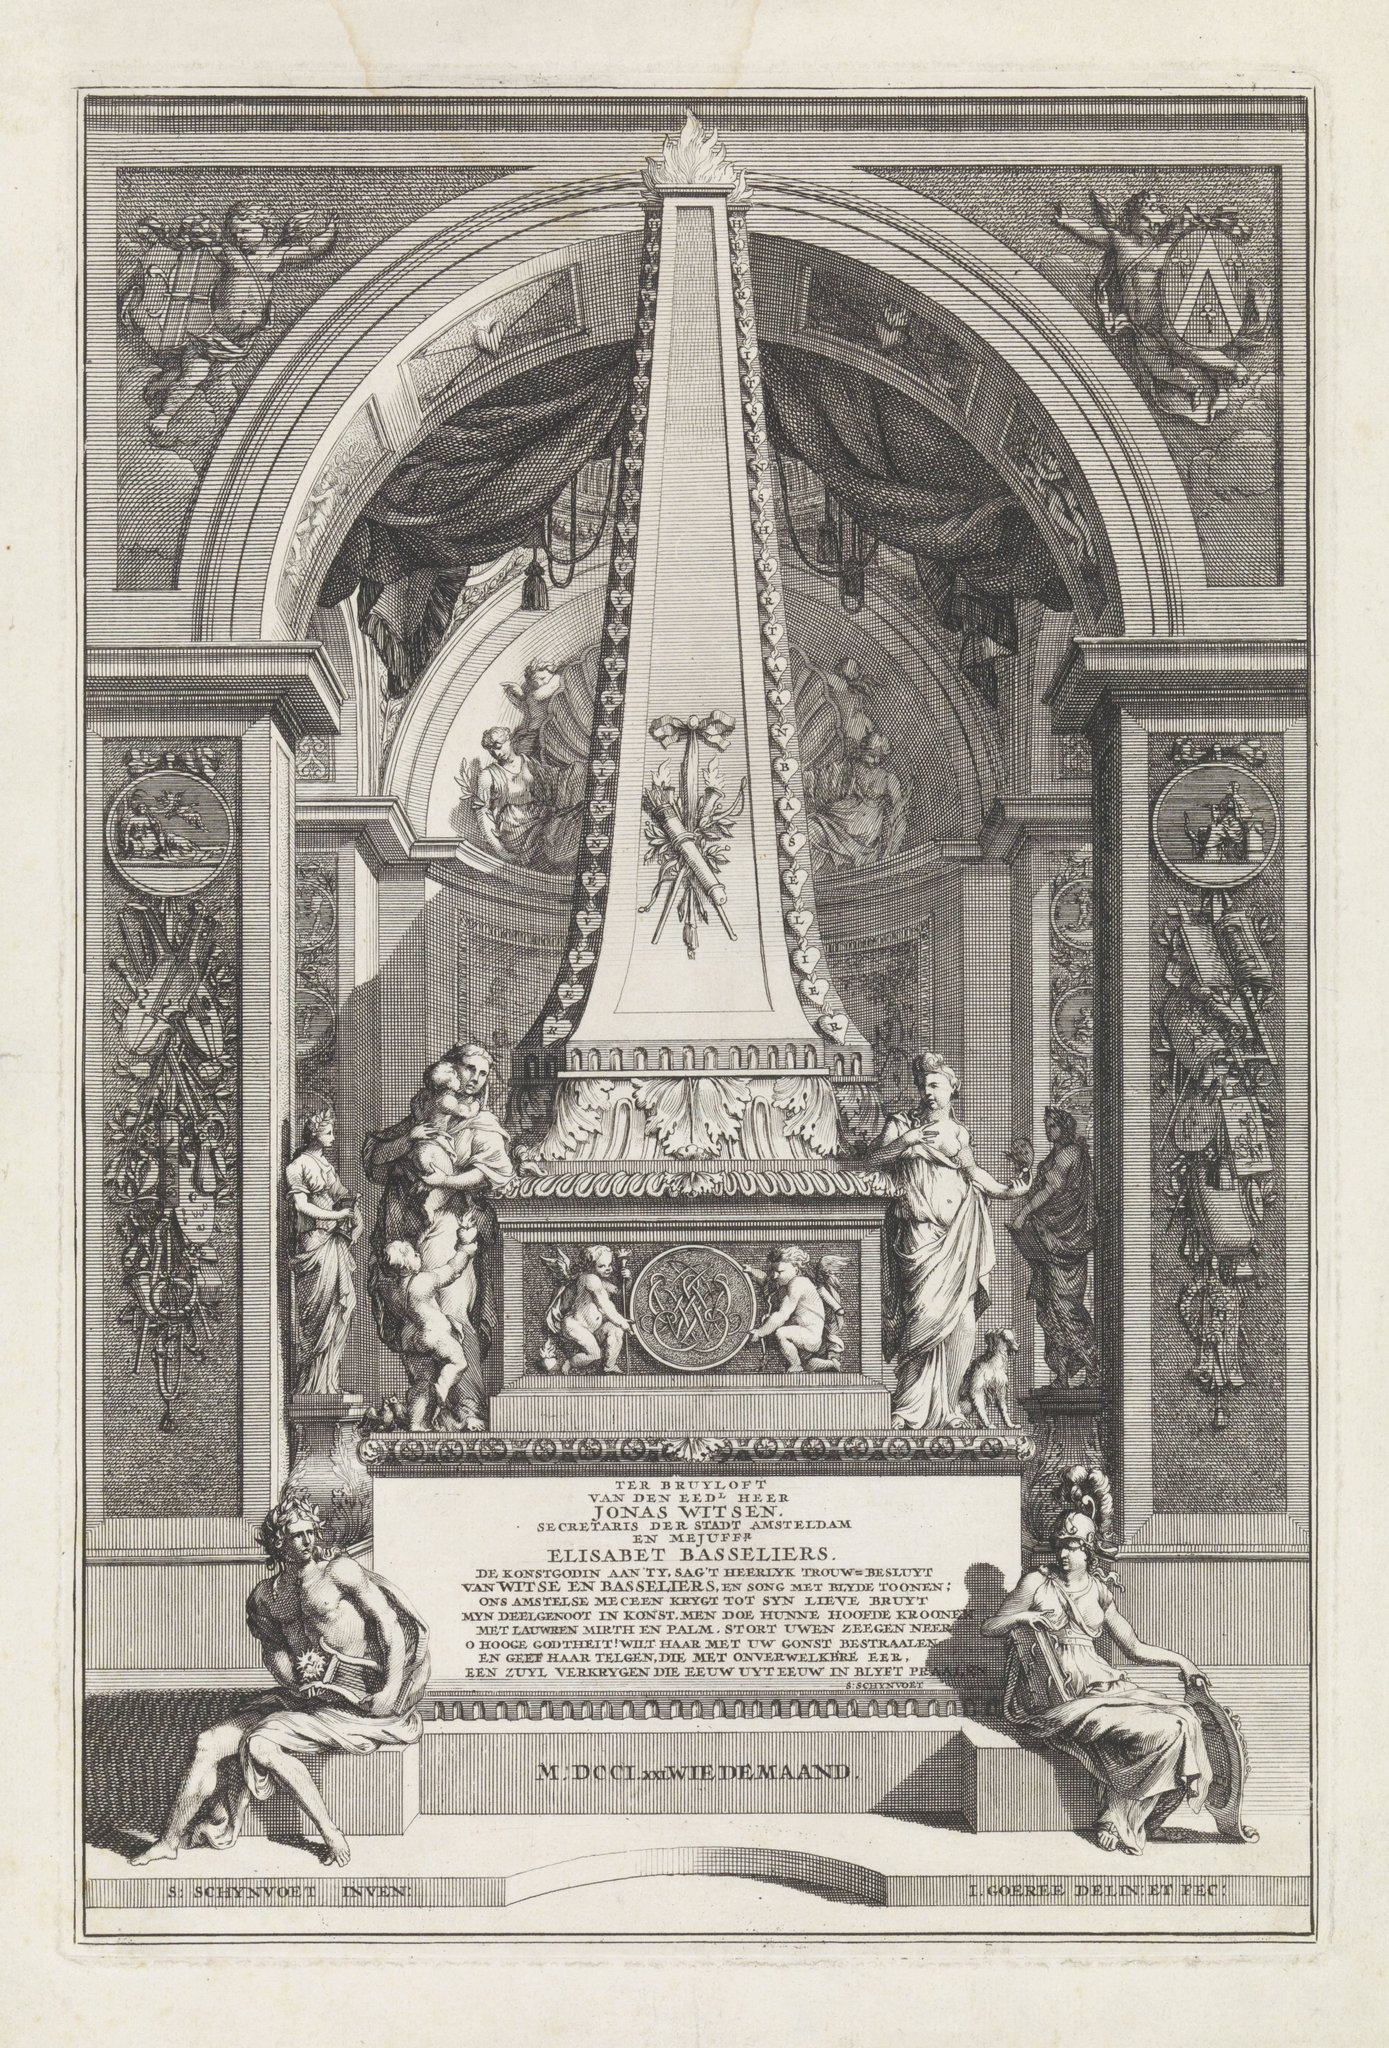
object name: print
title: Monument ter gelegenheid van de bruiloft van Jonas Witsen en Elisabet Basseliers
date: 1701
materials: paper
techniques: engraving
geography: amsterdam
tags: print maker, mayor, jonas witsen, charity, 'caritas'; 'carità' (ripa) ~ one of the three theological virtues, (story of) apollo (phoebus), (story of) minerva (pallas, athena), monument, statue, frankness, loyalty; 'lealtà', 'realtà' (ripa), cupids: 'amores', 'amoretti', 'putti', ornamenting, decorating ~ applied arts (+ monumental art)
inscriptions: collector's mark: Lugt 2228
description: Een nis met een monument versierd met ornamenten. Links van het monument de personificatie Liefde. Rechts de personificatie Trouw. Links van het monument zit Apollo, rechts Minerva. De prent is gemaakt ter ere van de bruiloft van Jonas Witsen en Elisabet Basseliers